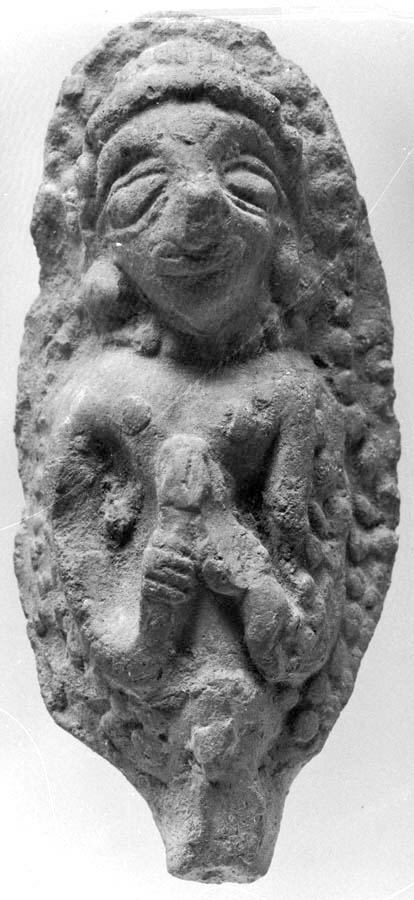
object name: relief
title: Relief of a Female Deity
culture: indian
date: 300-101 BCE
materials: terracotta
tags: maurya,mauryan